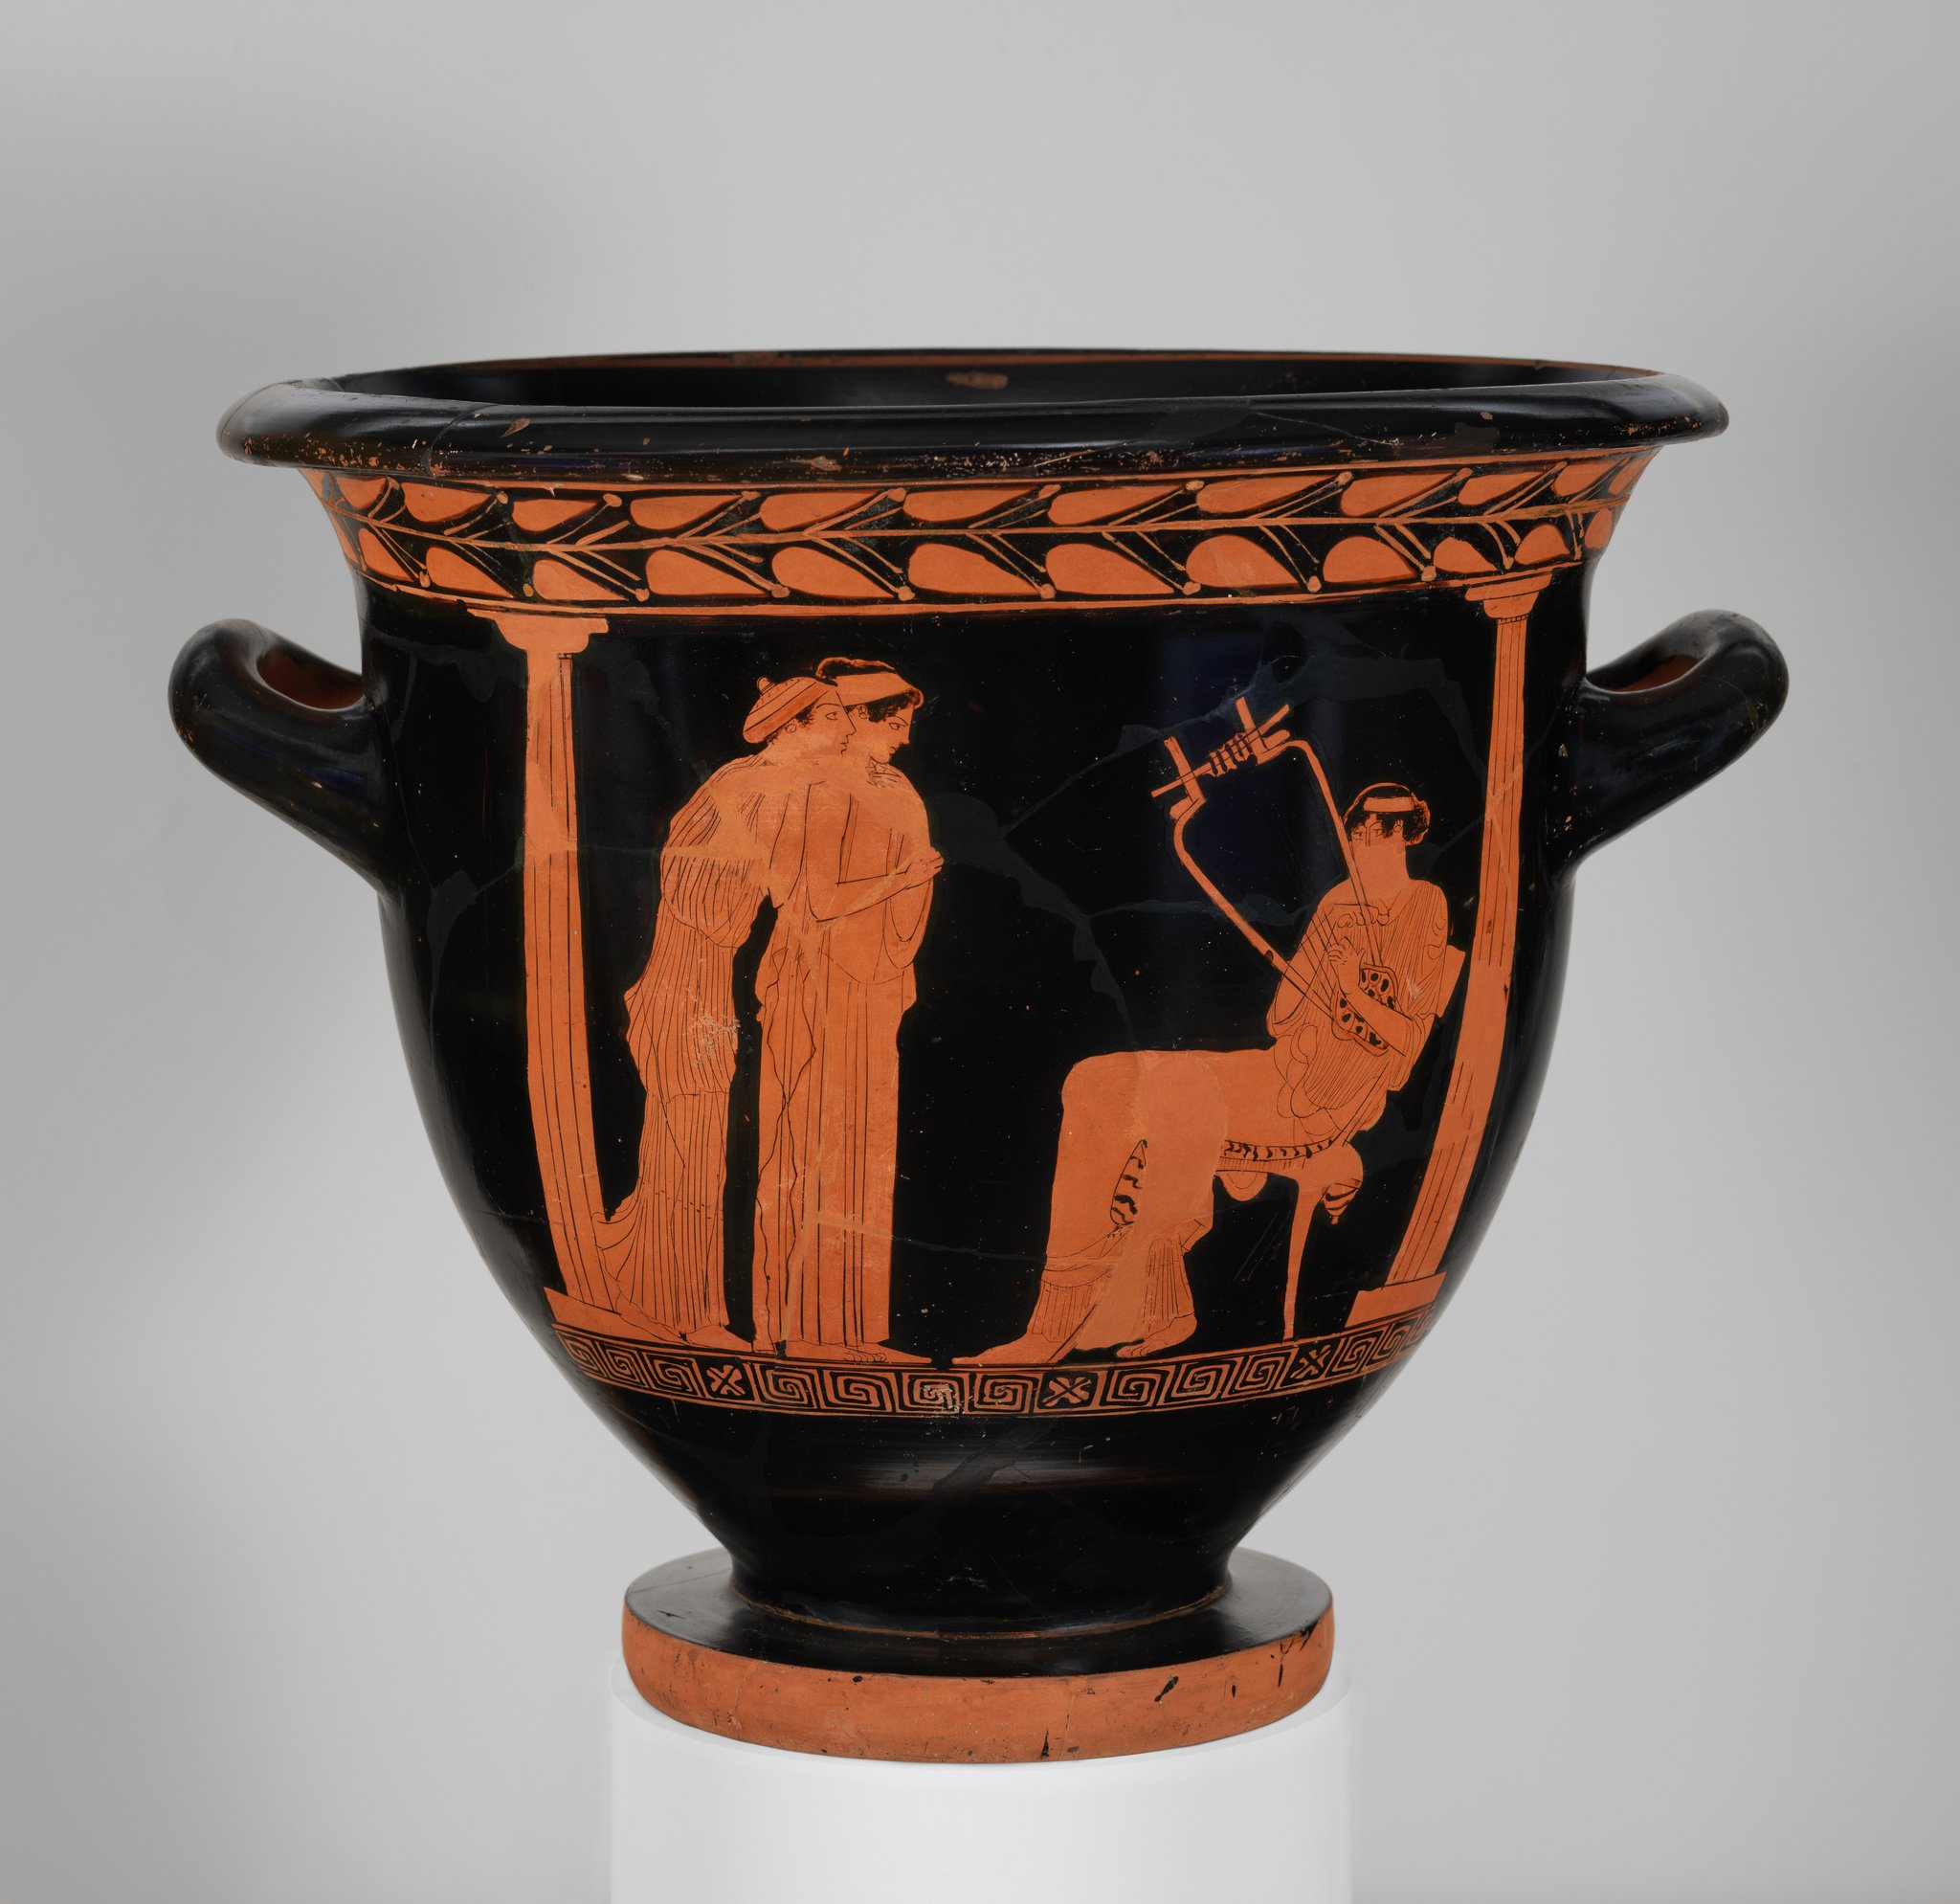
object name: bell krater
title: Terracotta bell-krater (bowl for mixing wine and water)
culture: greek, attic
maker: danaë painter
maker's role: artist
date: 460 BCE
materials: terracotta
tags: women,lyres